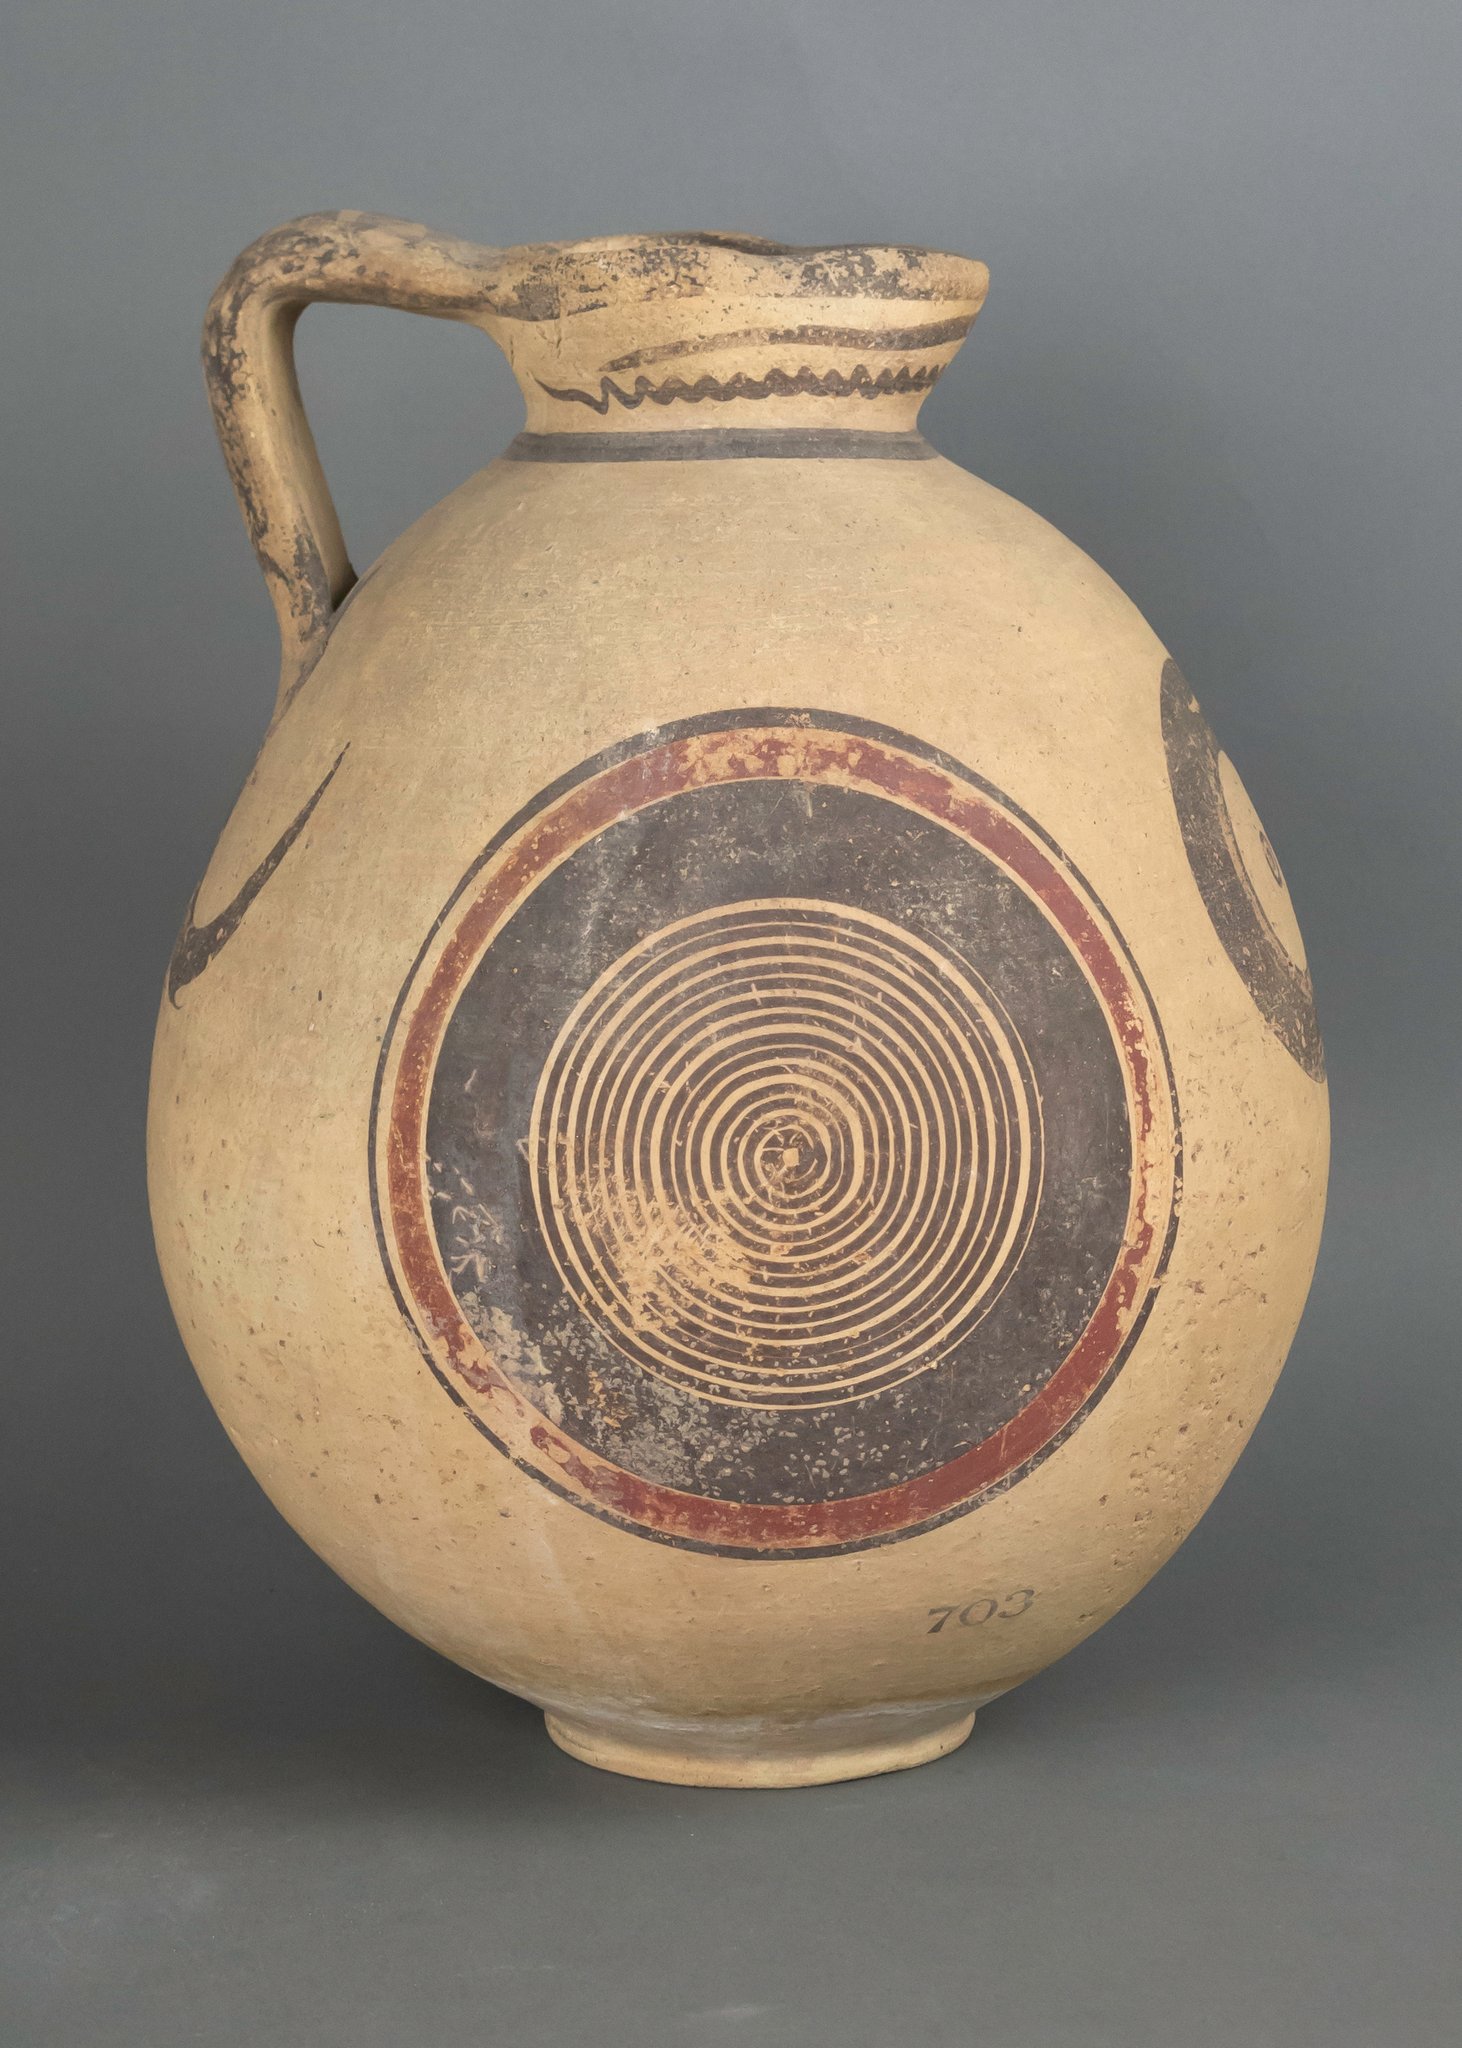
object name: jug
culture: cypriot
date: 600-480 BCE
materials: terracotta